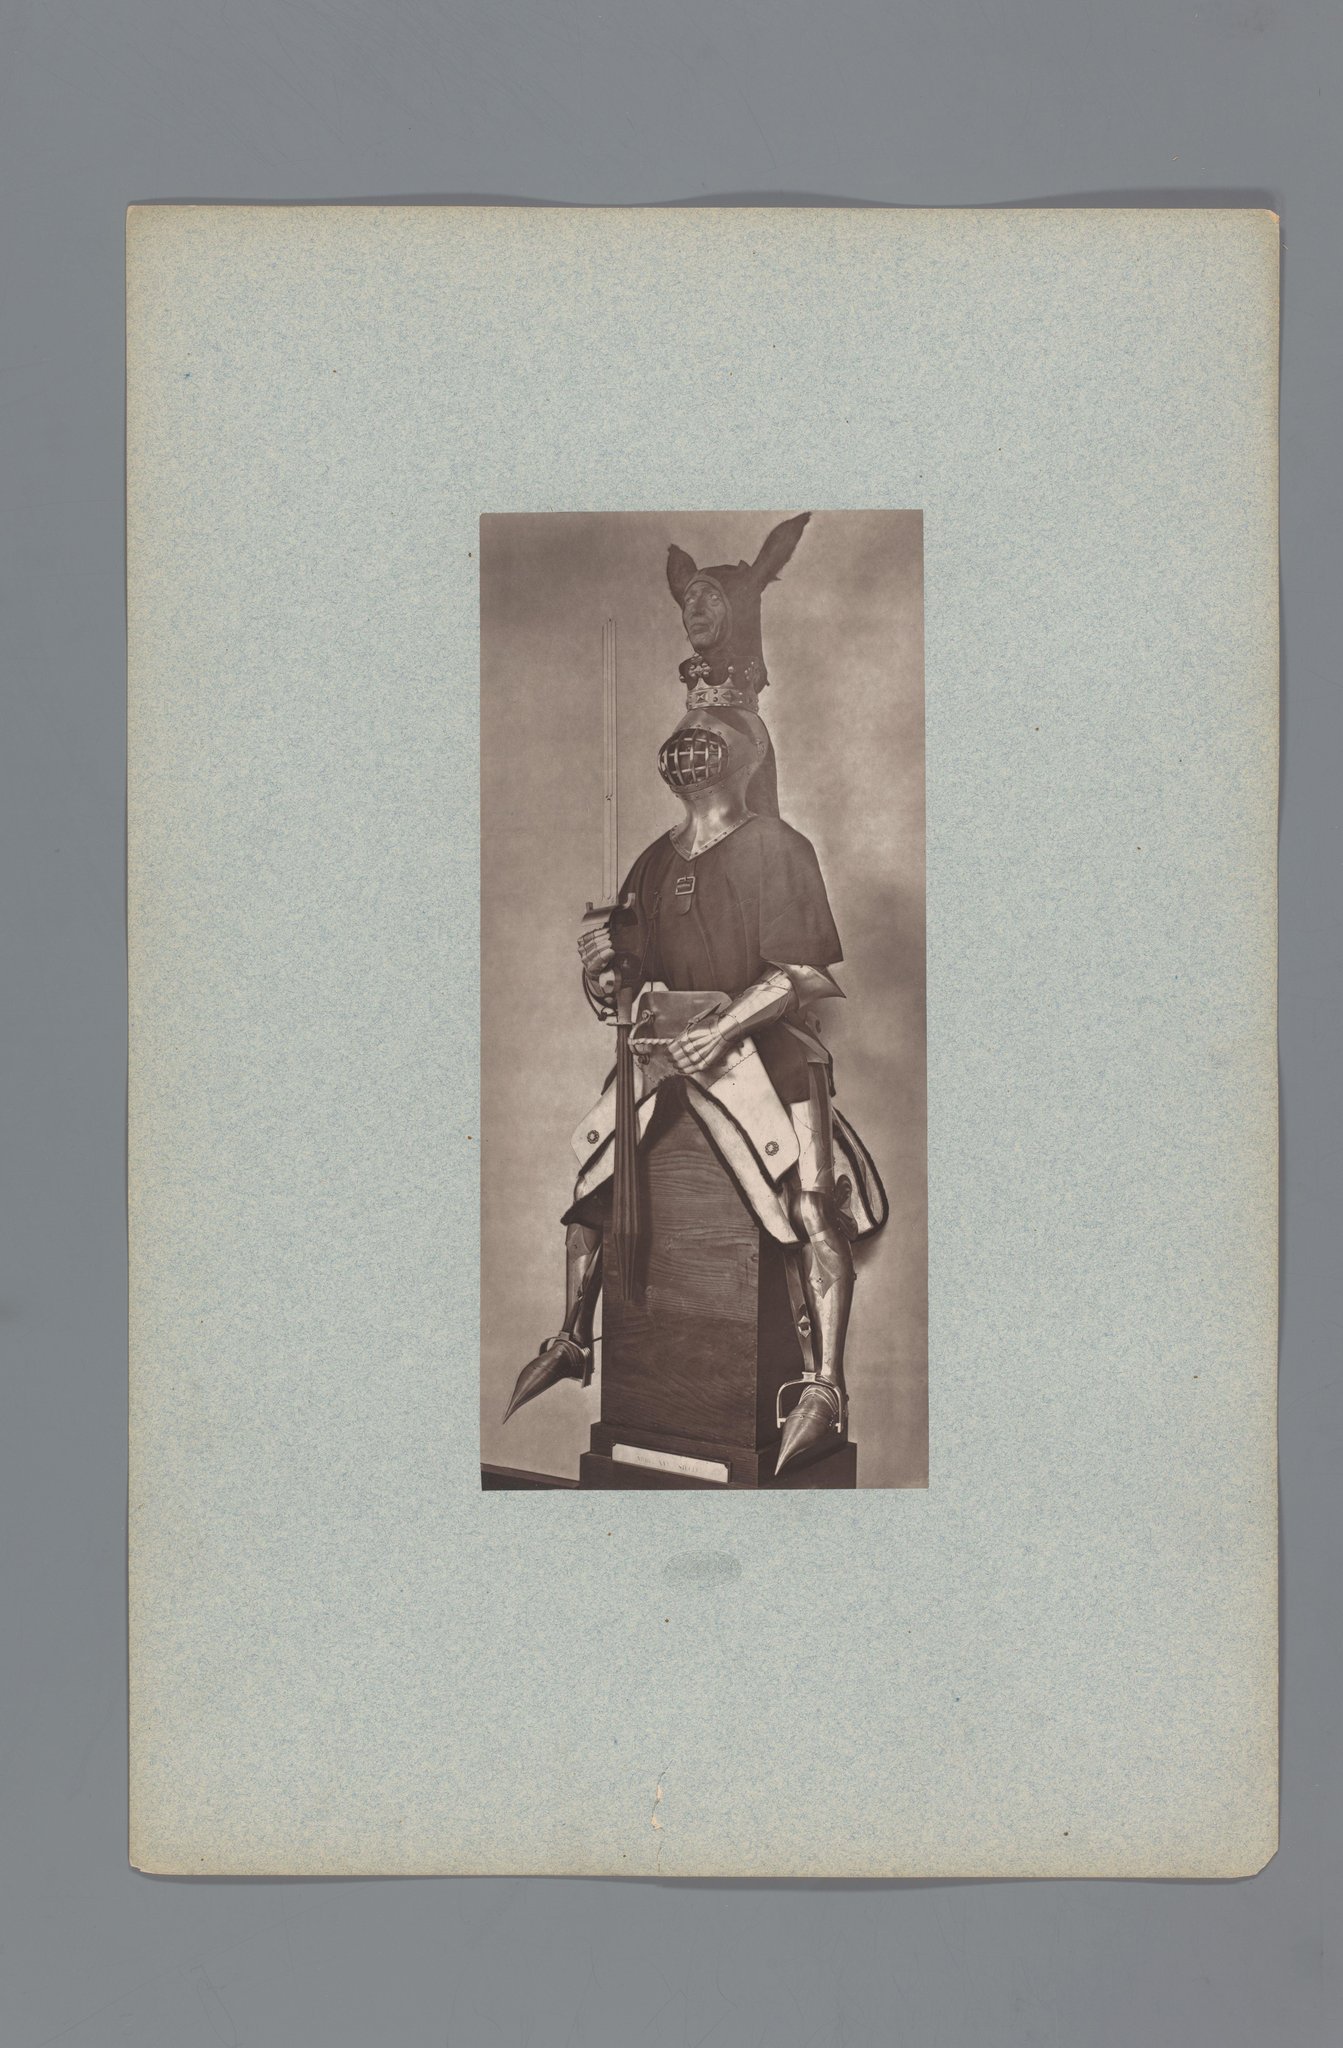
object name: photomechanical print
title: 15de-eeuws harnas voor een ruiter uit het leger van Karel VII van Frankrijk, uit de collectie van het Musée d'Artillerie in Parijs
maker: Anonymous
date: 1877-1882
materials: paper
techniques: woodburytype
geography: paris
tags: armour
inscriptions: check stamp: ‘PHOTOGLYPTIE/ LEMERCIER ET Cie/ PARIS’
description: Deze prent maakt deel uit van een omslag met 36 prenten, een titelblad en een lijst van afbeeldingen.